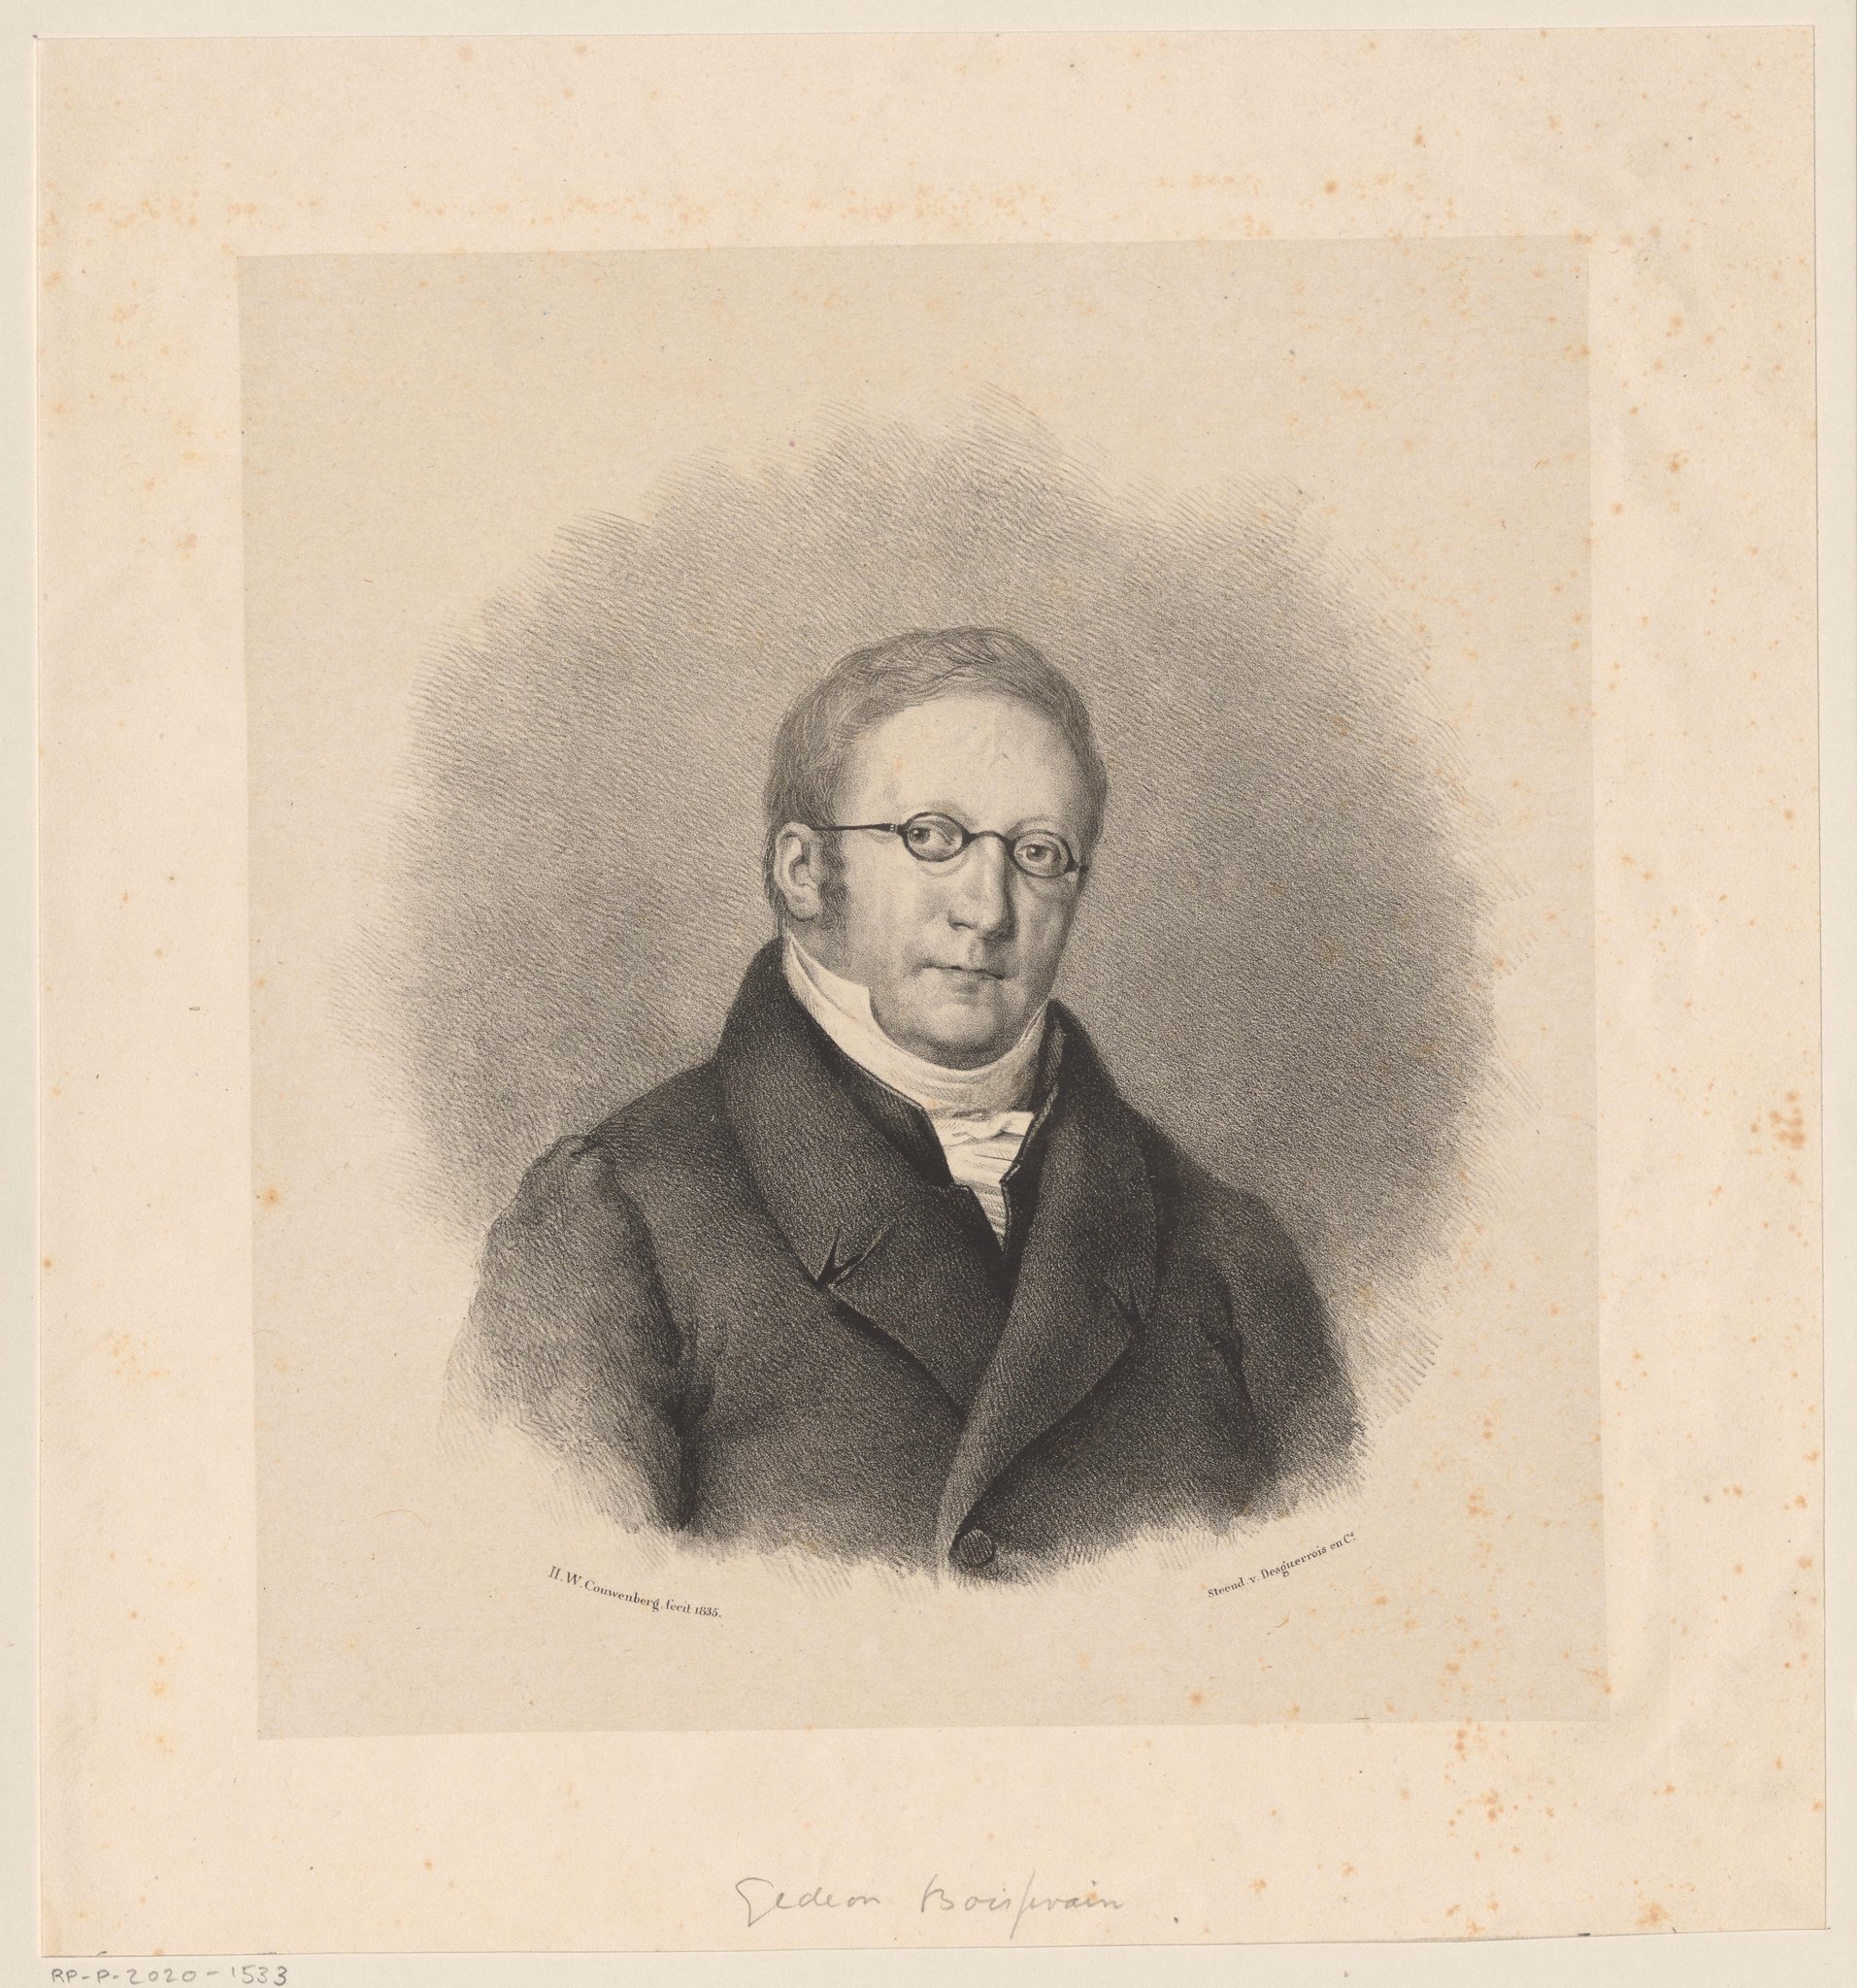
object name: print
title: Portret van Gideon Jeremie Boissevain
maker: henricus wilhelmus couwenberg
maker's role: draughtsman, print maker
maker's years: 1814-1845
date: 1835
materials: paper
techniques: lithograph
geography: amsterdam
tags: historical persons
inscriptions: date